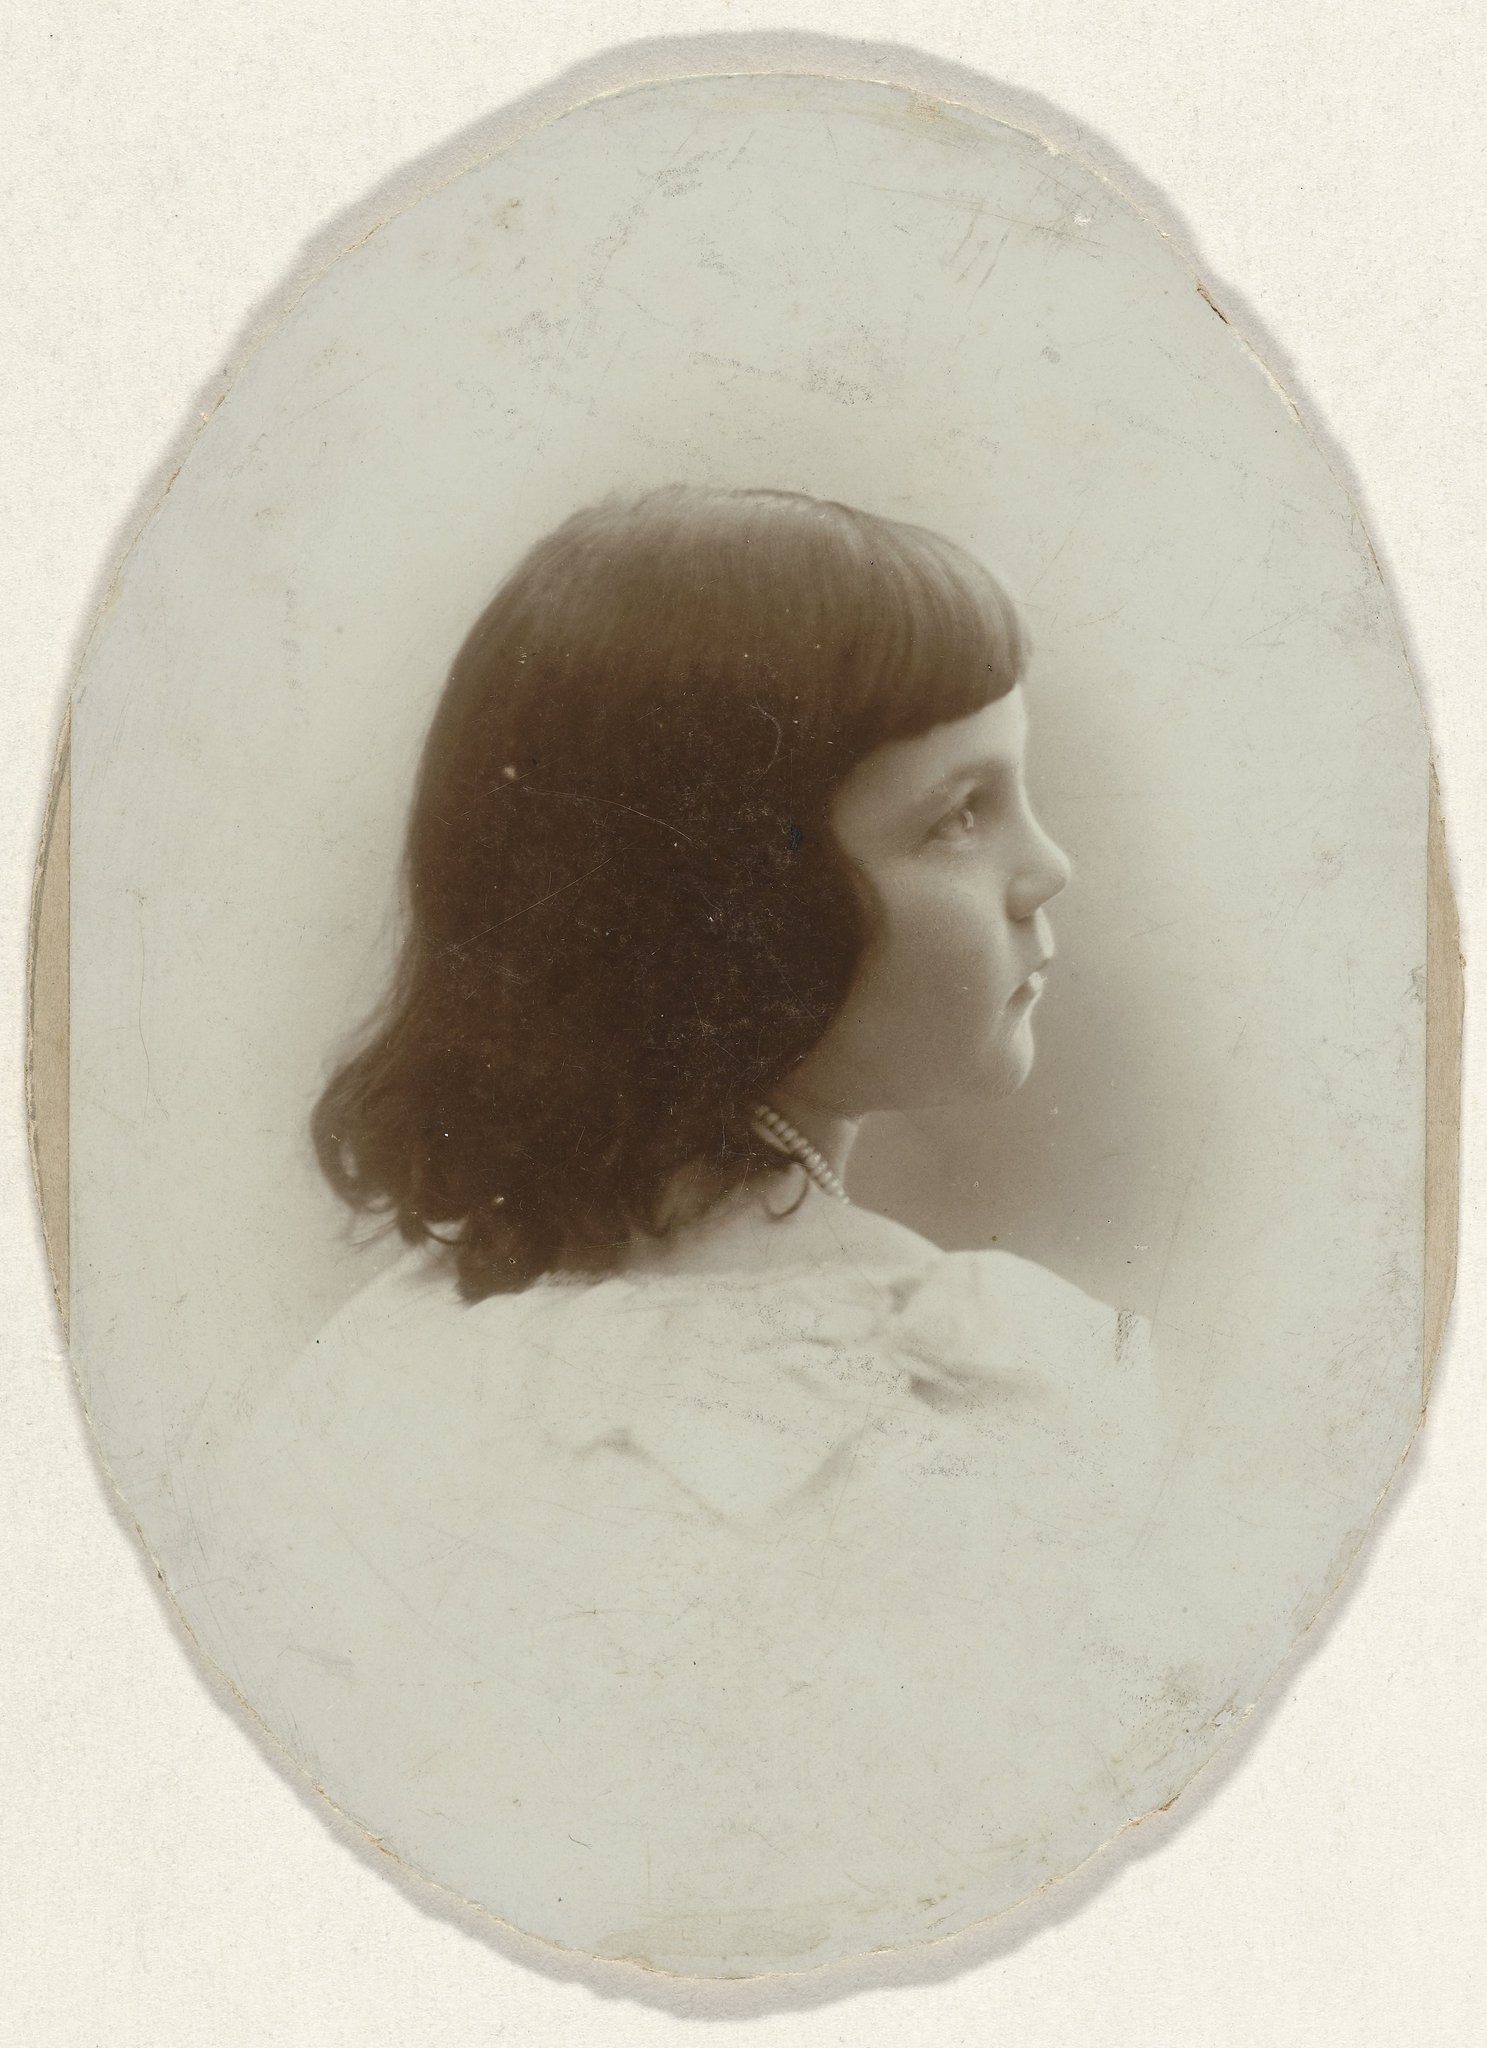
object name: photograph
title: Studioportret van Cornelia Vermeulen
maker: cornelis johannes lodewicus vermeulen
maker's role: fotograaf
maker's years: 1861-1936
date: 1910-1940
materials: photographic support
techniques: albumen print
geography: the hague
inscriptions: inscription: ‘Cornelia, toen ze 5 jaar was overleden aan menigitis. Komt na Tine of na Flop’